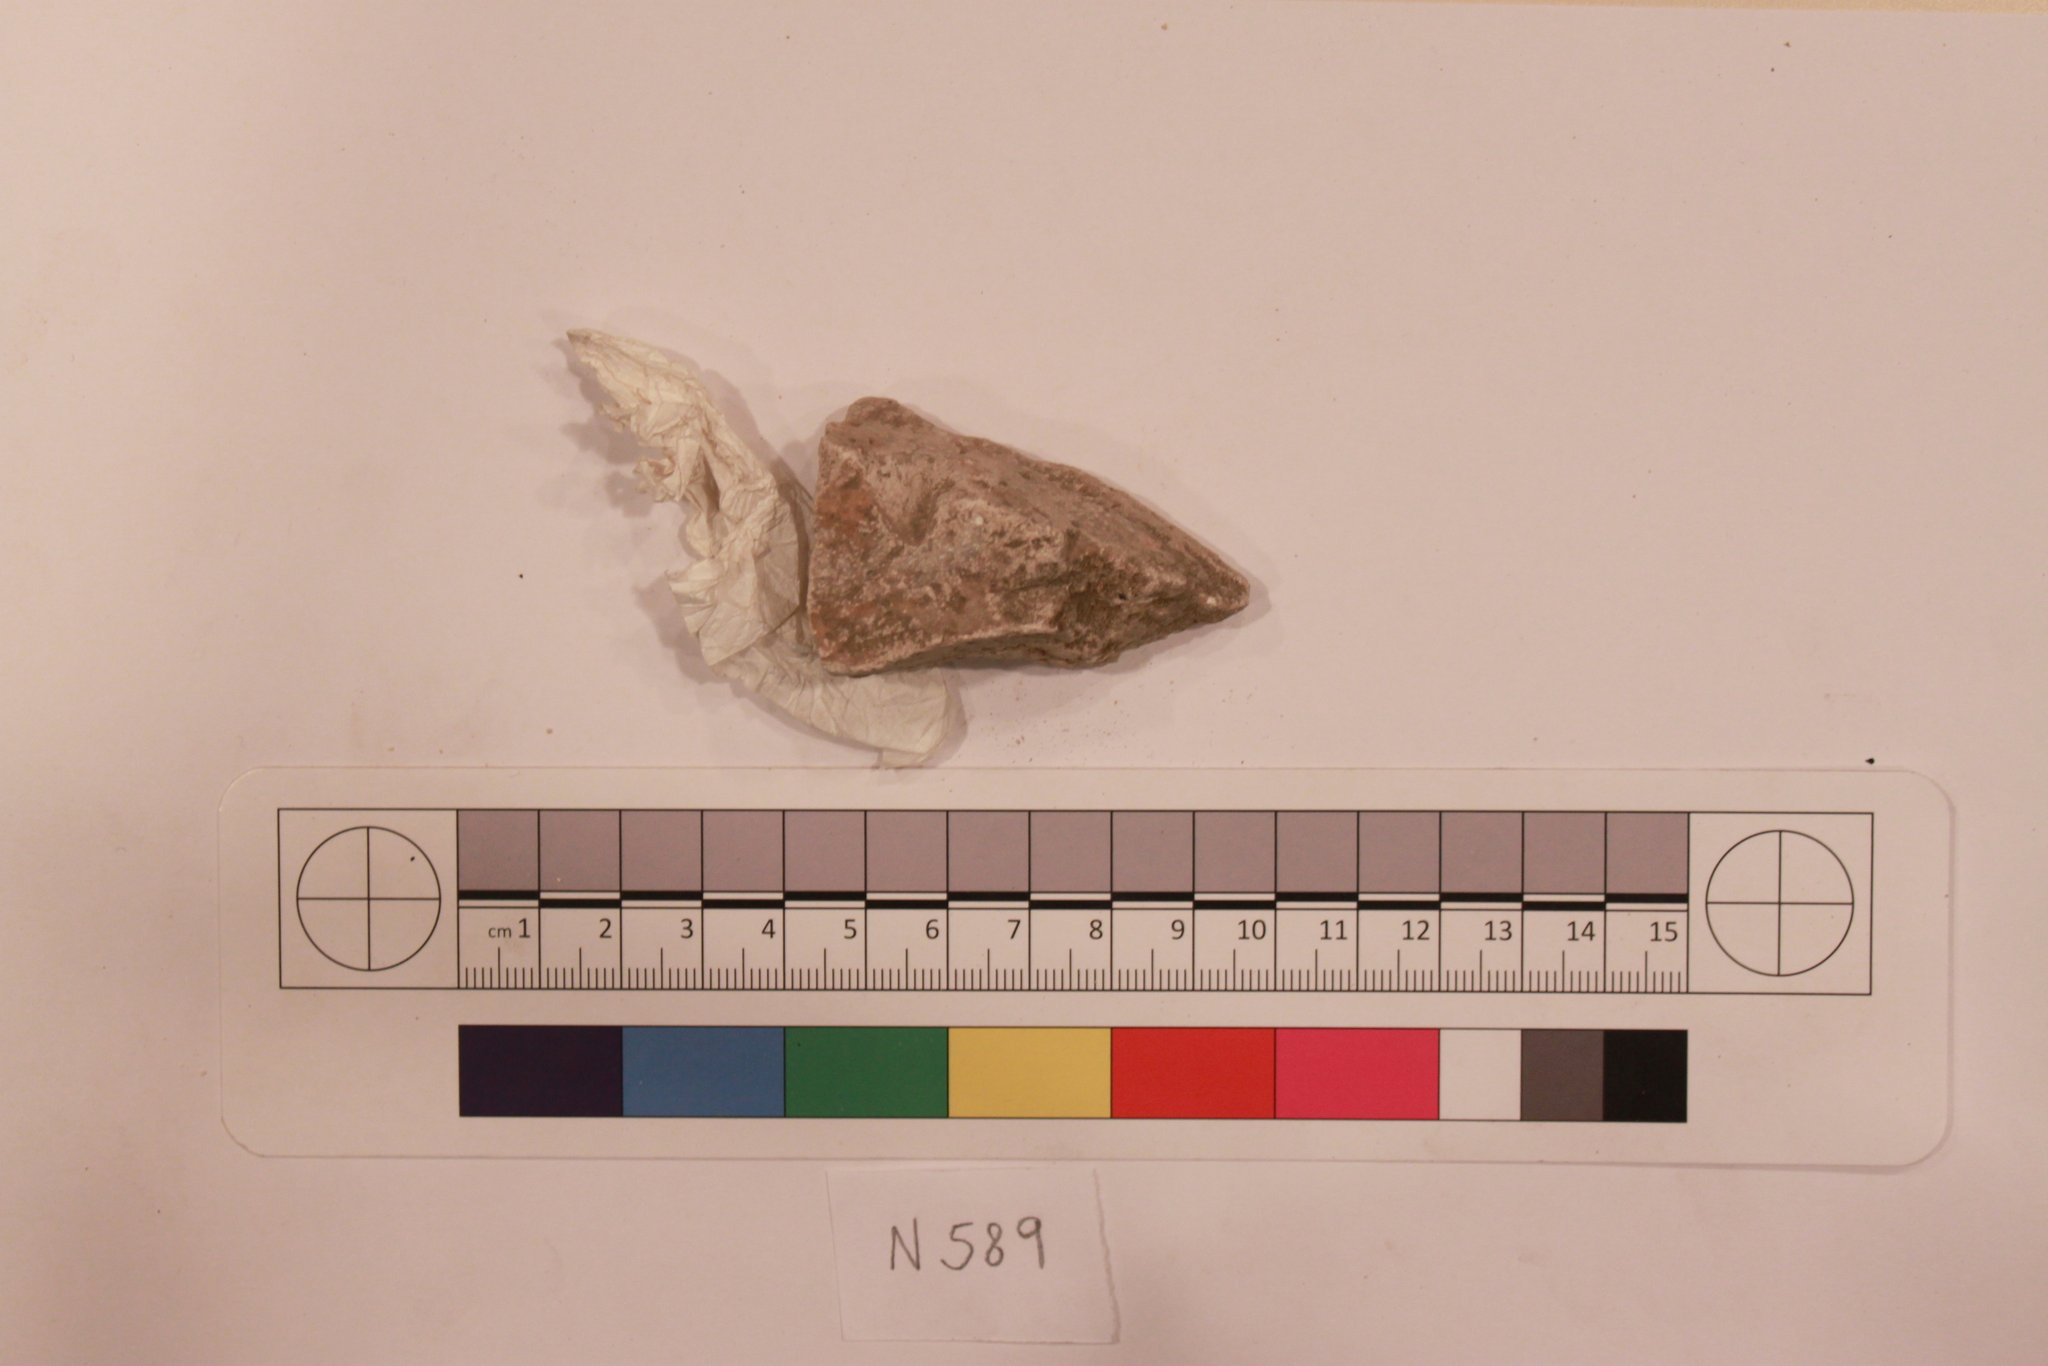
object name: fragment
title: Stucco Fragment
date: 701-1200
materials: plaster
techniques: carving, painting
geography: iran